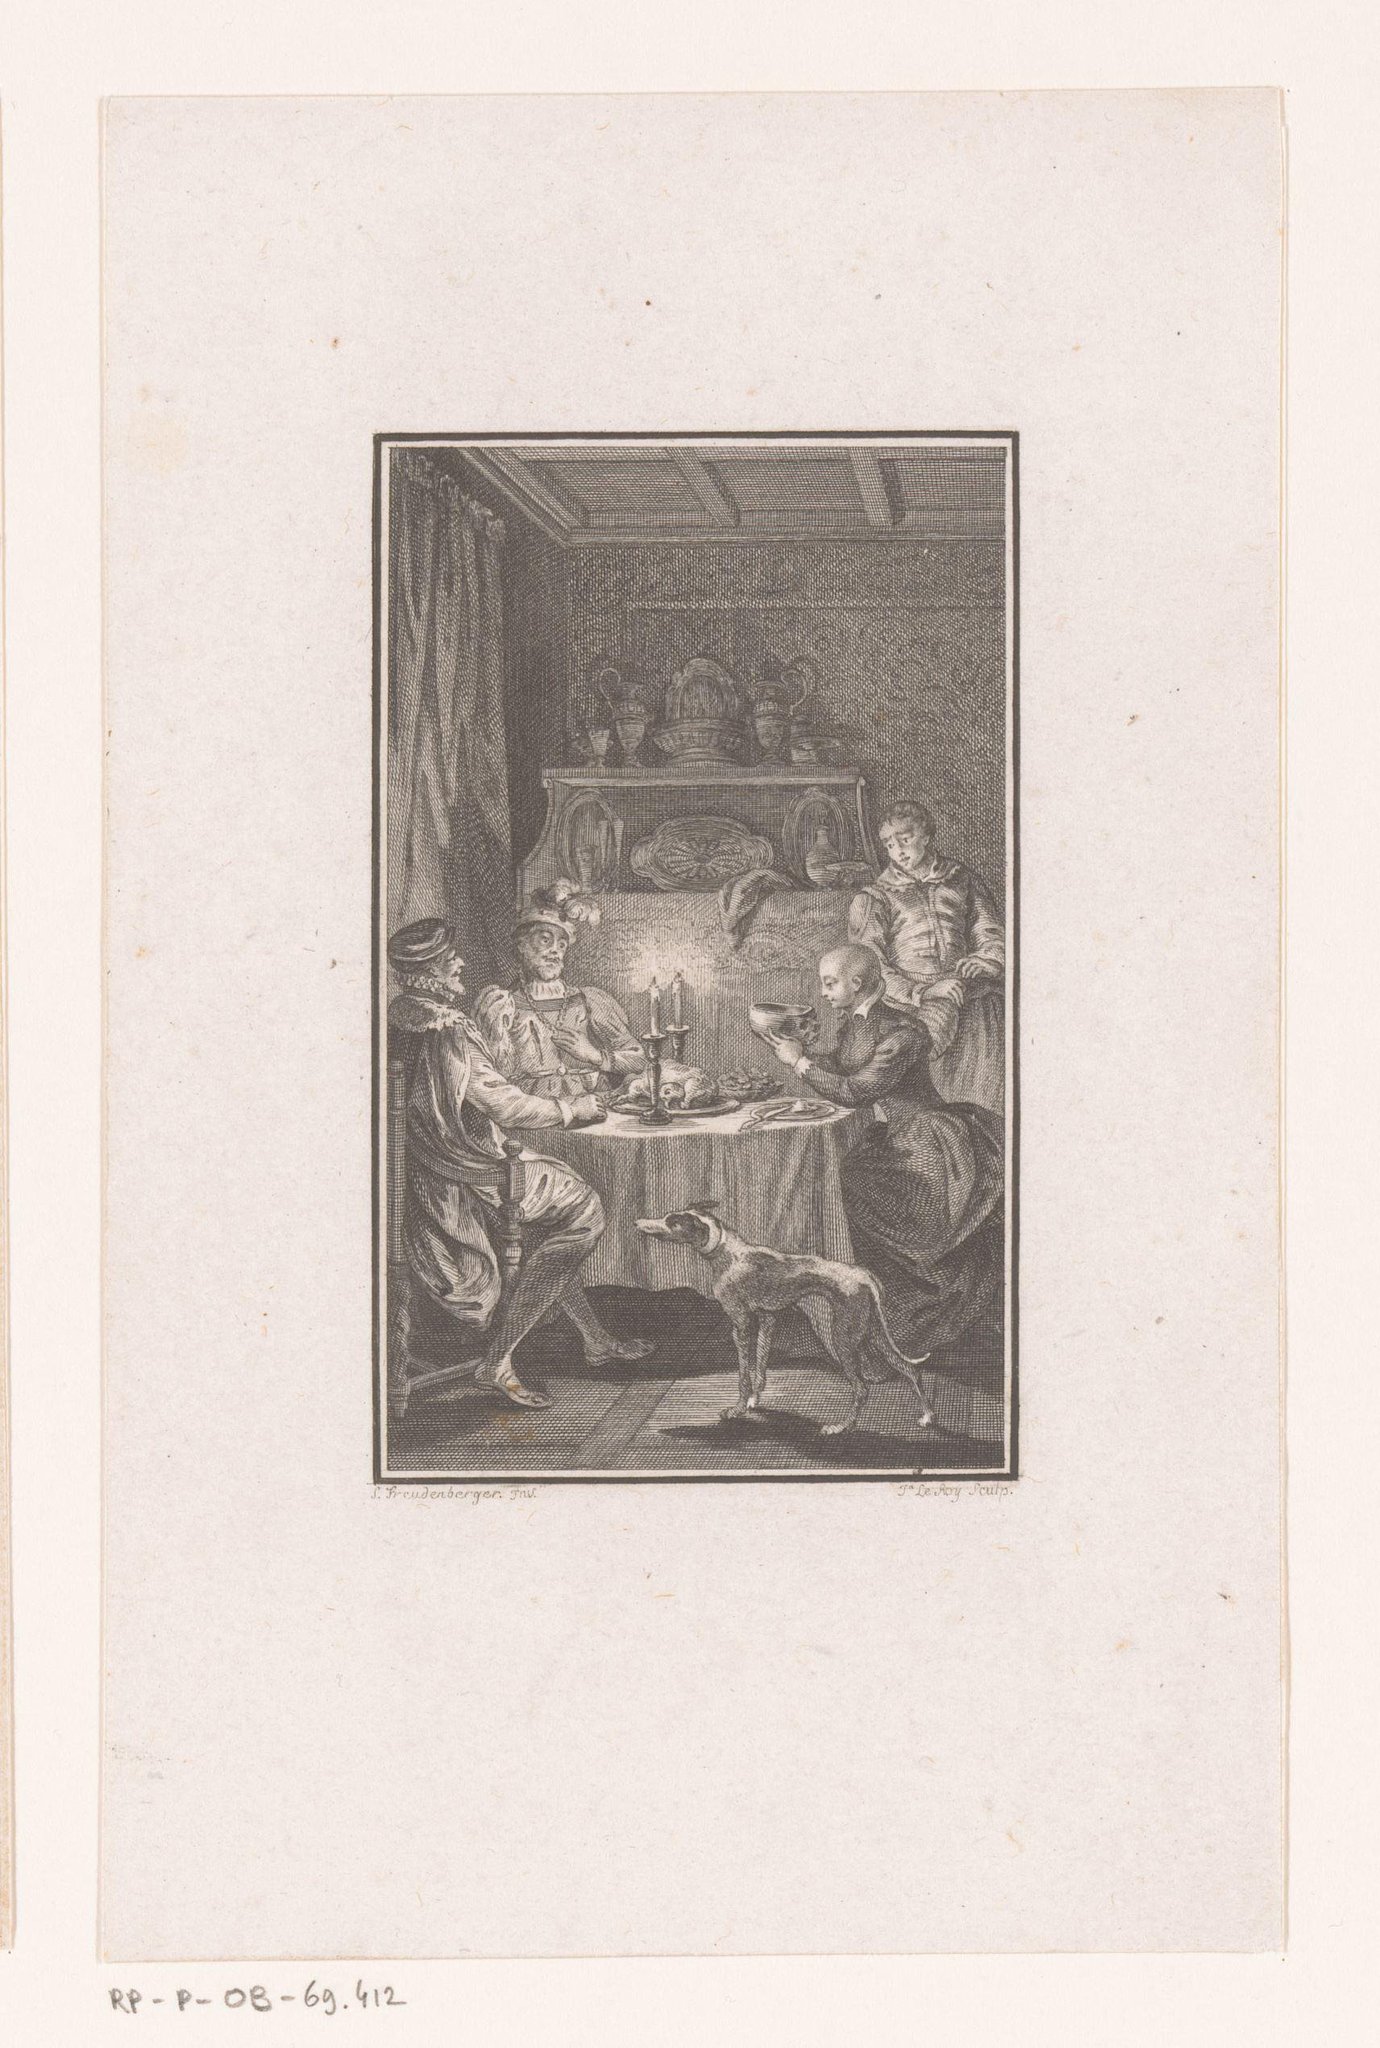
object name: print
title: Twee mannen en een kale vrouw met schedel aan een door kaarsen verlichte tafel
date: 1749-1799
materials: paper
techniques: etching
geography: bern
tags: (human) skull, baldness - aa - ~ women, dog, nobility and patriciate; chivalry, knighthood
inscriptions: collector's mark: Lugt 2228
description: Mogelijk prent uit: Les Nouvelles de Marguerite, reine de Navarre. Bern: la nouvelle Société Typographique, 1780-1781.